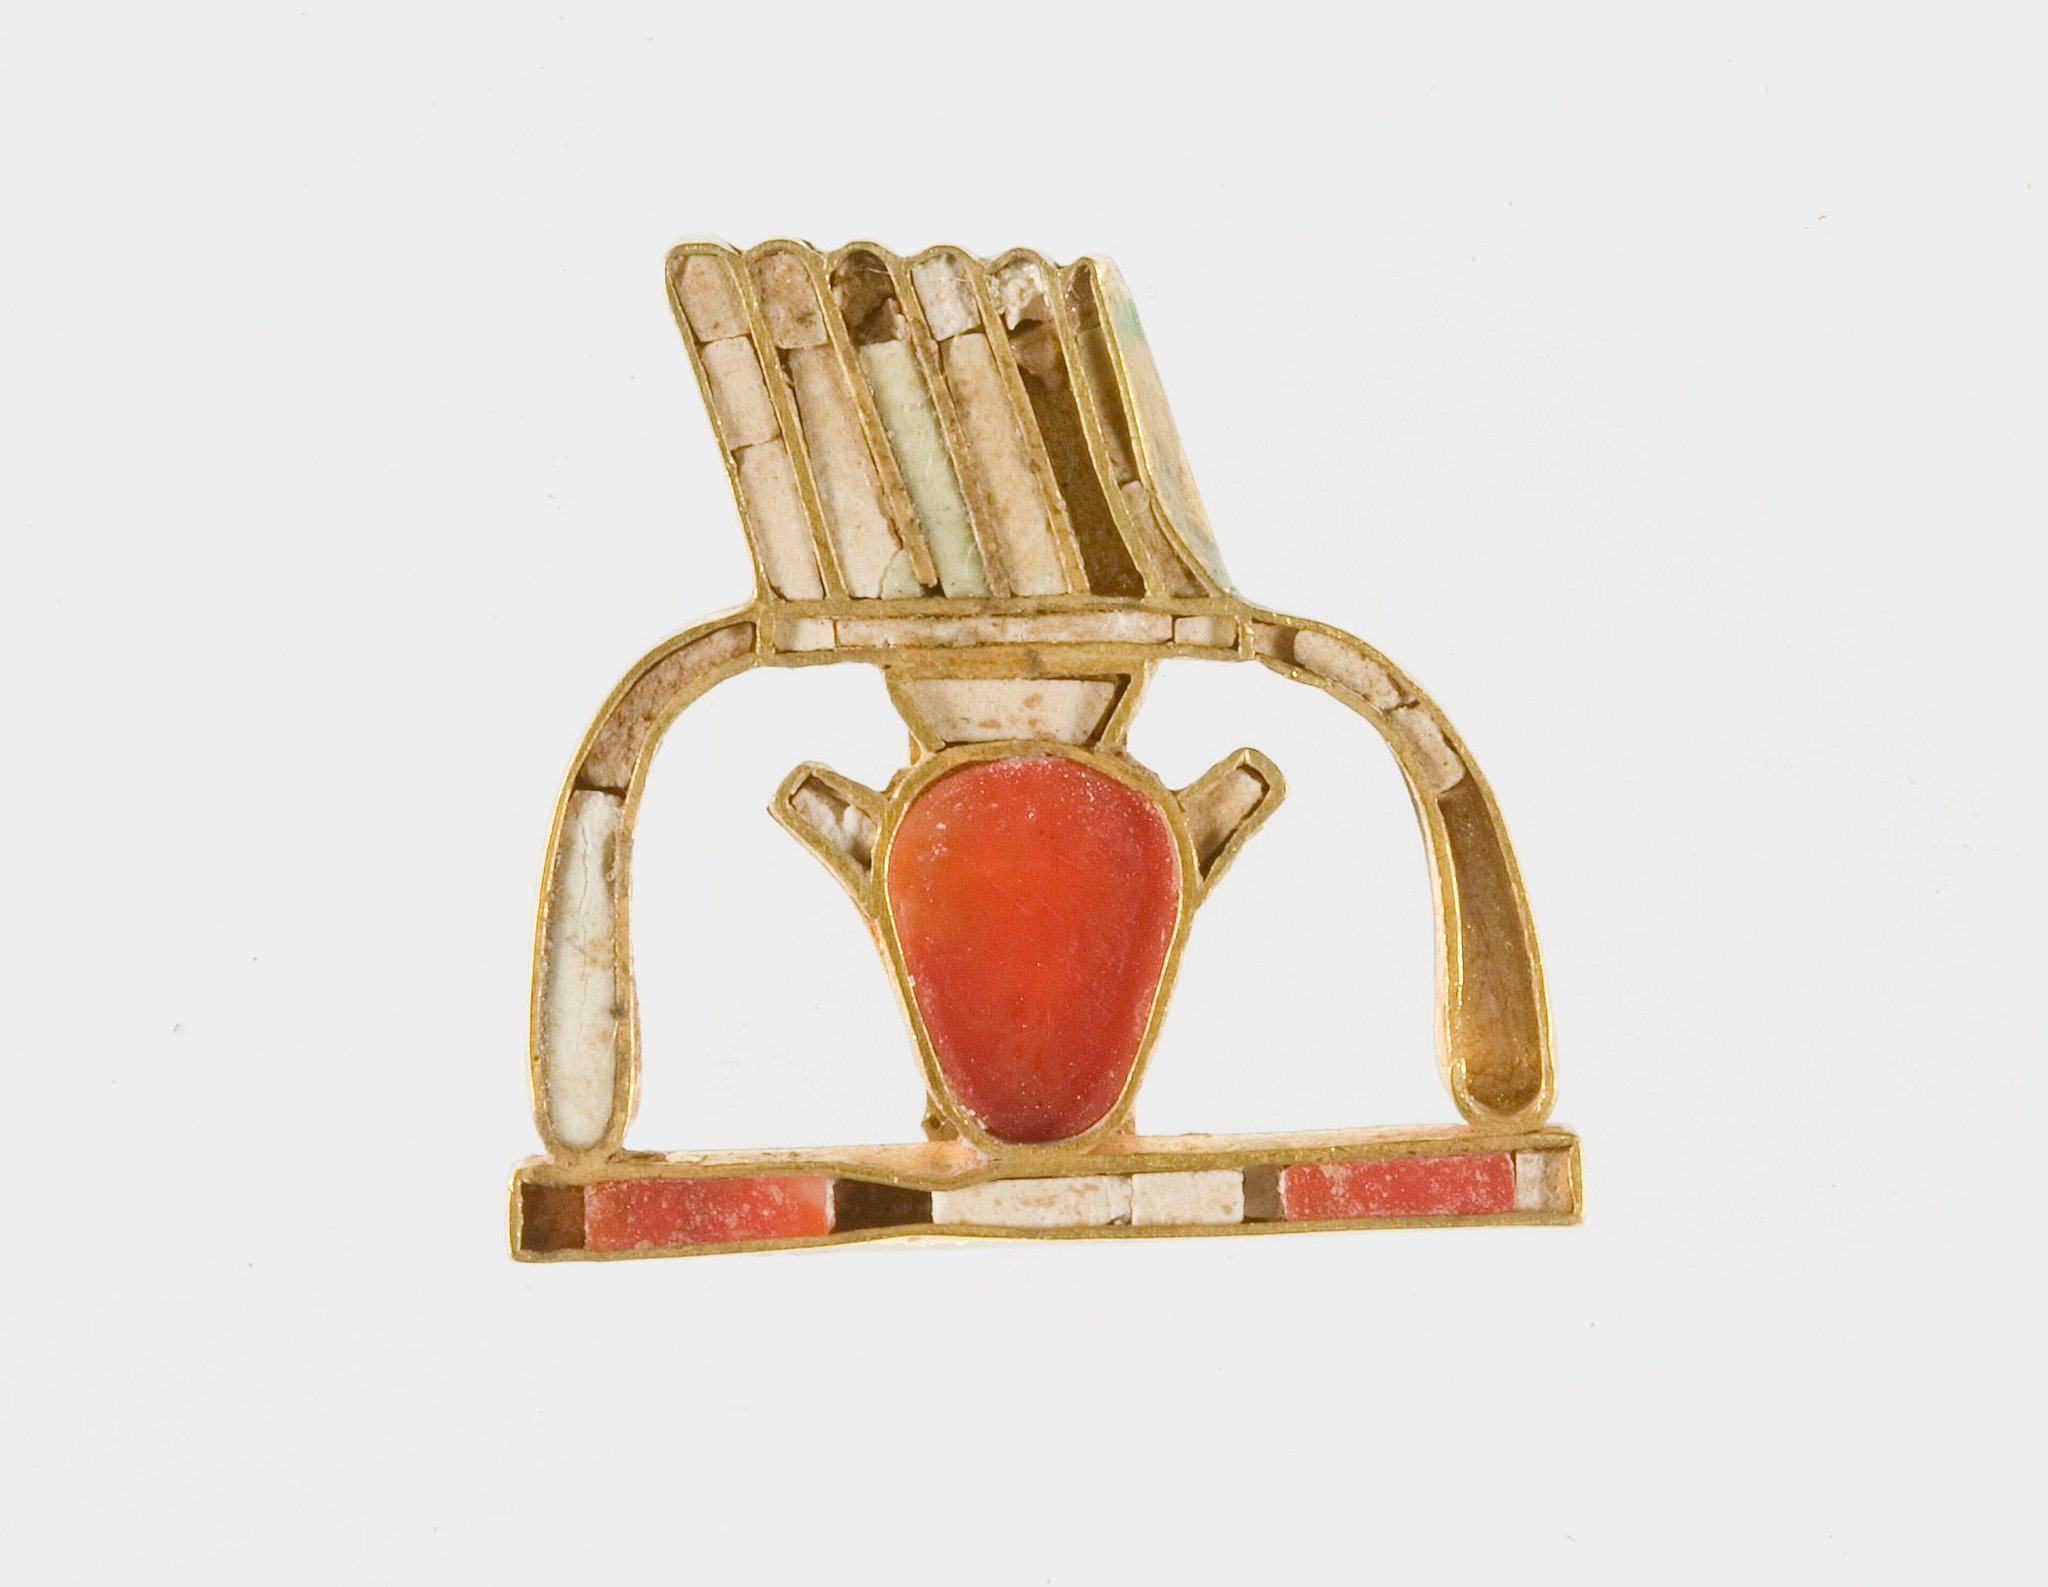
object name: amulet, sithathoryunet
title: Motto Clasp of Sithathoryunet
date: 1887-1813 BCE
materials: gemstone, gold, paste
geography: egypt